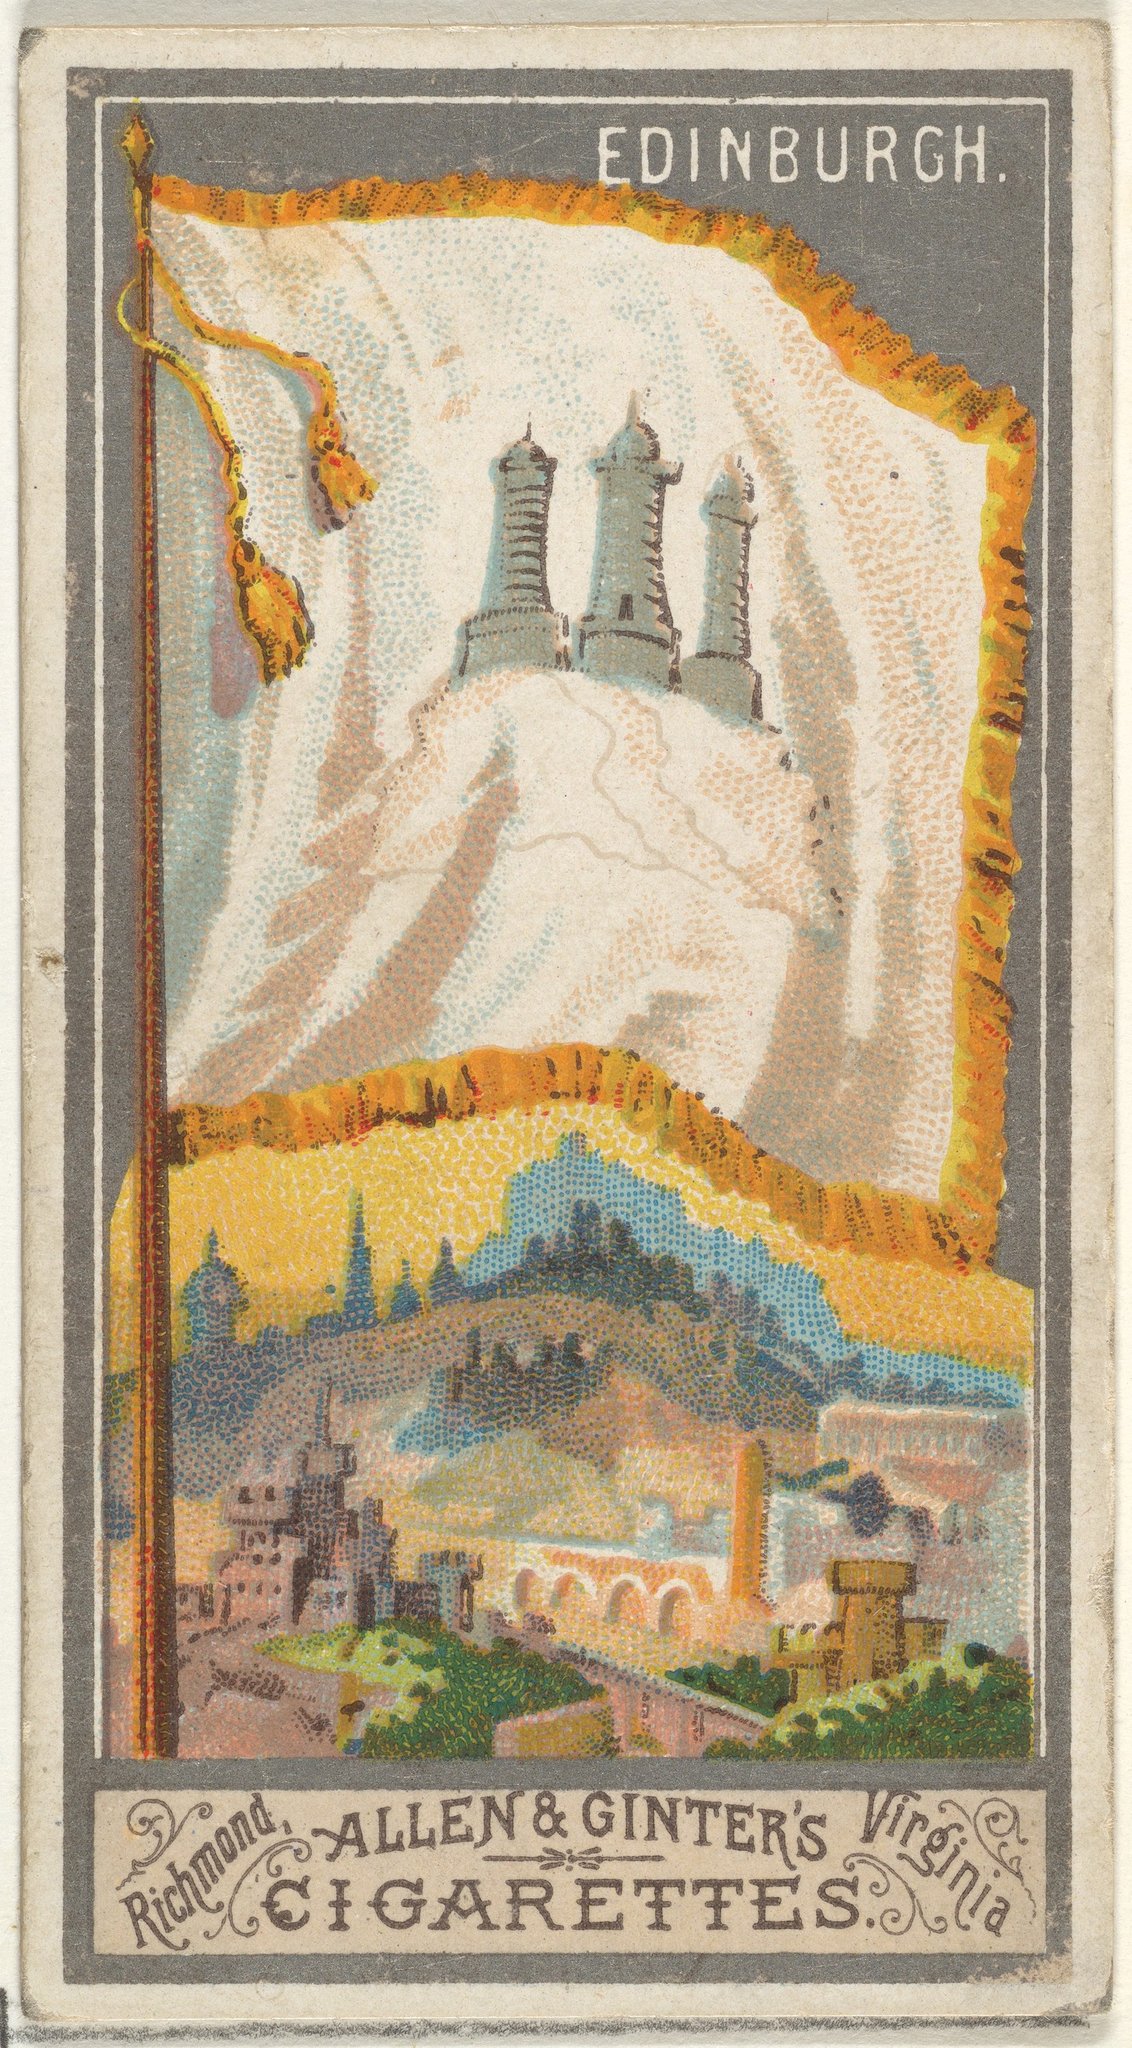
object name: print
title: Edinburgh, from the City Flags series (N6) for Allen & Ginter Cigarettes Brands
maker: allen & ginter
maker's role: publisher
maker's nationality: american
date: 1887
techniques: color lithograph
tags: flags